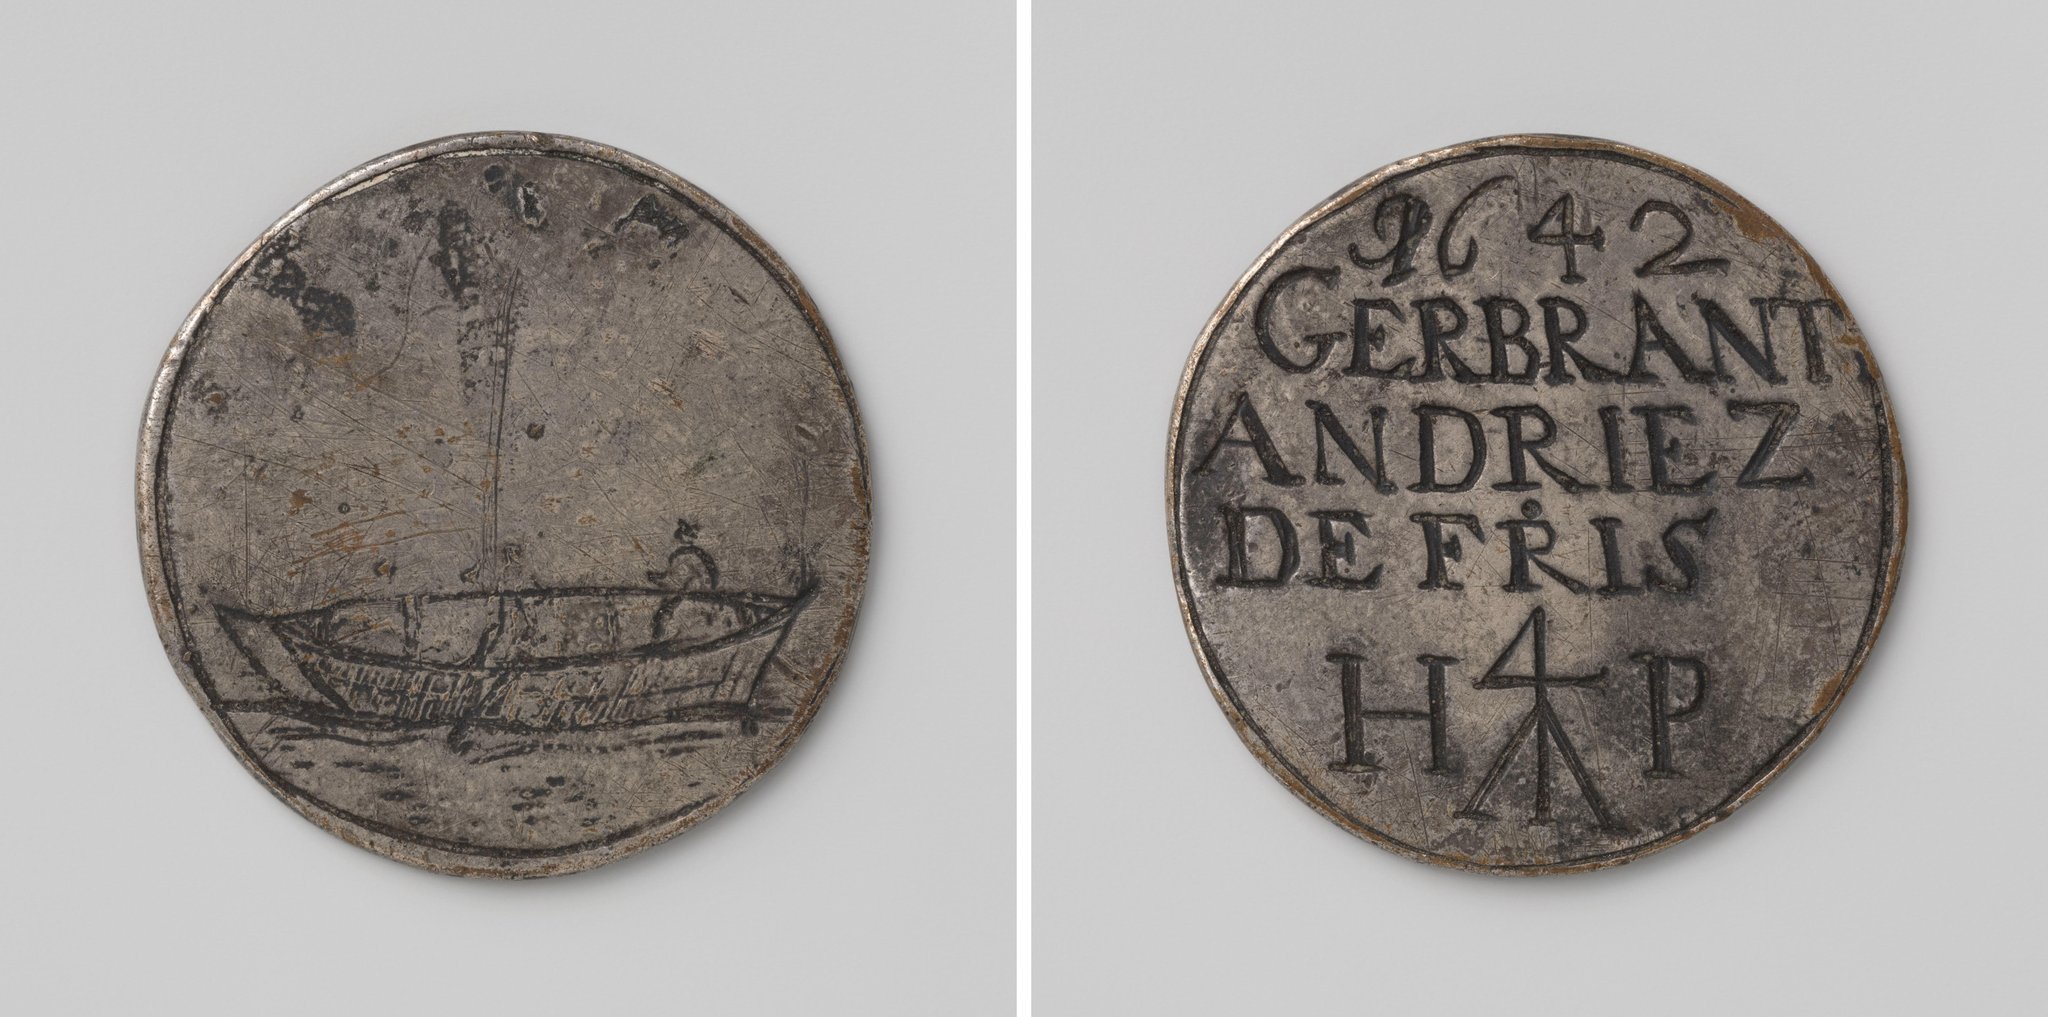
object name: medal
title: Vlotschuitvoerdersgilde van Amsterdam, gildepenning van Gerbrandt Andriez de Fris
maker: Anonymous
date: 1642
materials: silver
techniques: engraving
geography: amsterdam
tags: amsterdam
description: Zilveren penning. Voorzijde: schuit waar man in zit. Keerzijde: opschrift boven monogram van letters H en P; daartussen huismerk